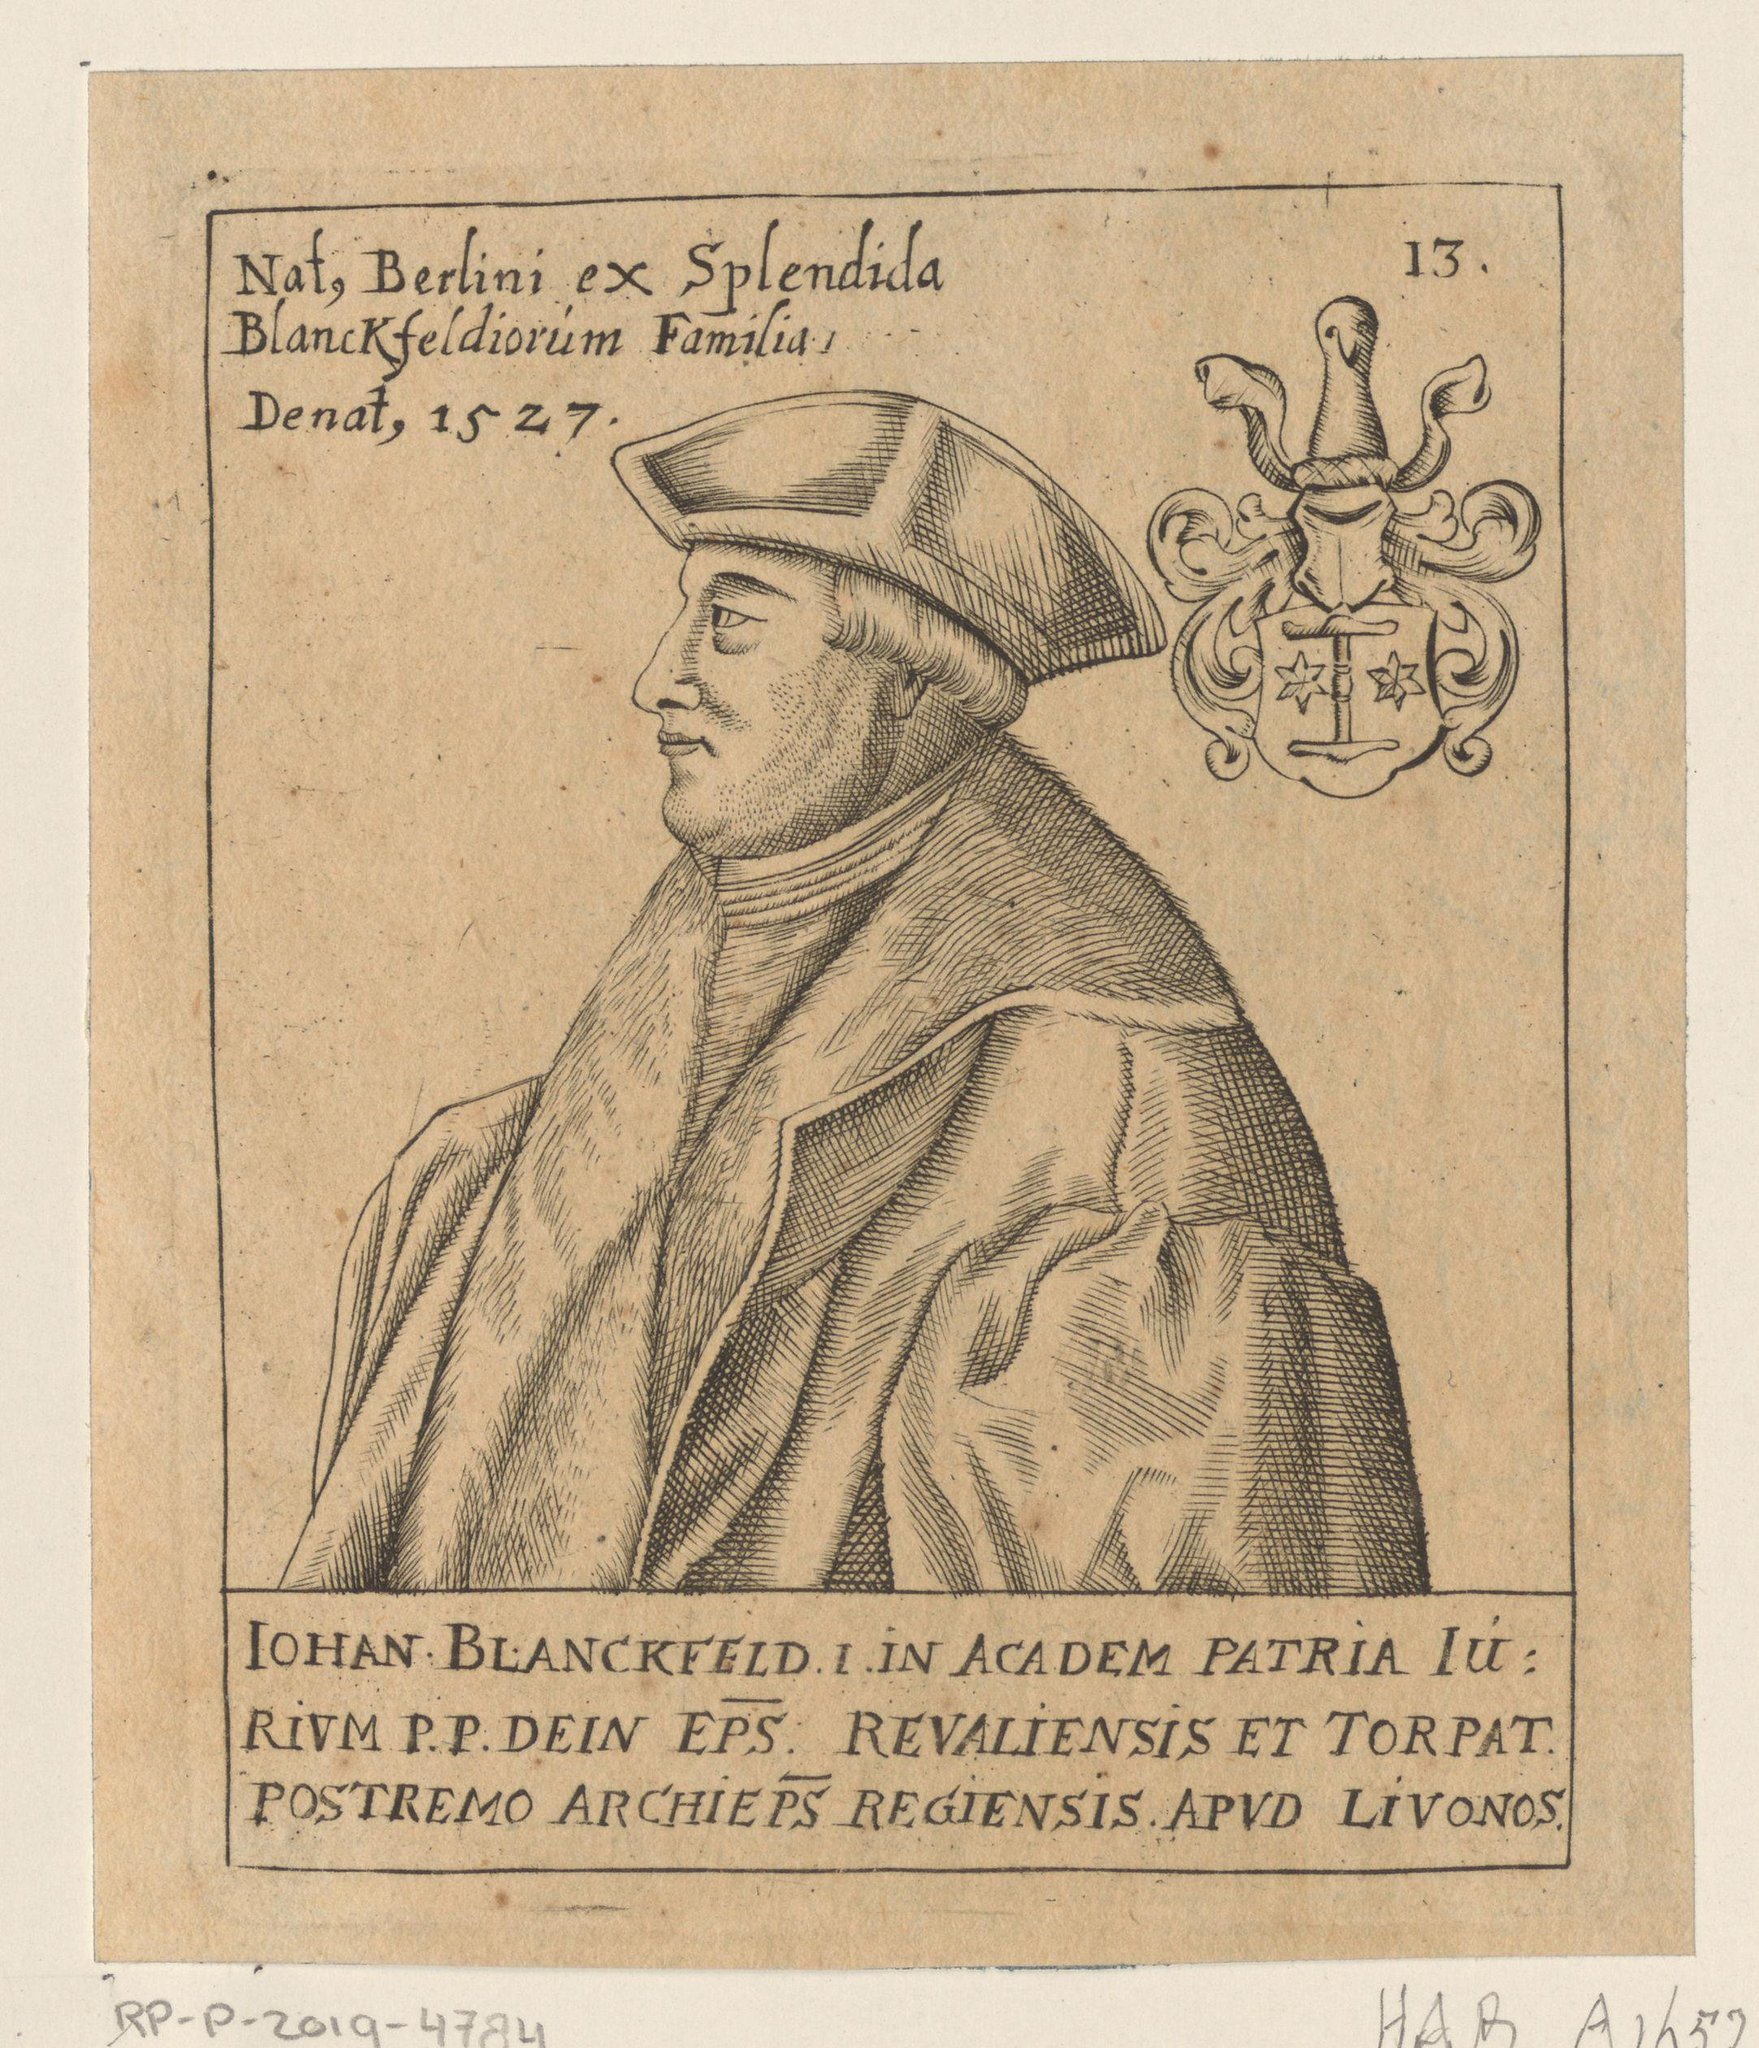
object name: book illustration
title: Icones et elogia virorum aliquot praestantium (...)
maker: Anonymous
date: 1671-1751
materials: paper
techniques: engraving, etching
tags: archbishop, bishop, etc. (roman catholic), theologian, historical persons, armorial bearing, heraldry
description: De prent is uitgegeven als onderdeel van een serie. Later is de prent mogelijk ook als boekillustratie gebruikt in: Küster, Georg Gottfried. Martin Friedrich Seidels Bilder-Sammlung in welcher hundert, gröstentheils in der Mark Brandenburg (…). Berlijn: Buchladen bey der Real-Schule, 1751. Het is onduidelijk tot welke uitgave de huidige prent behoort.